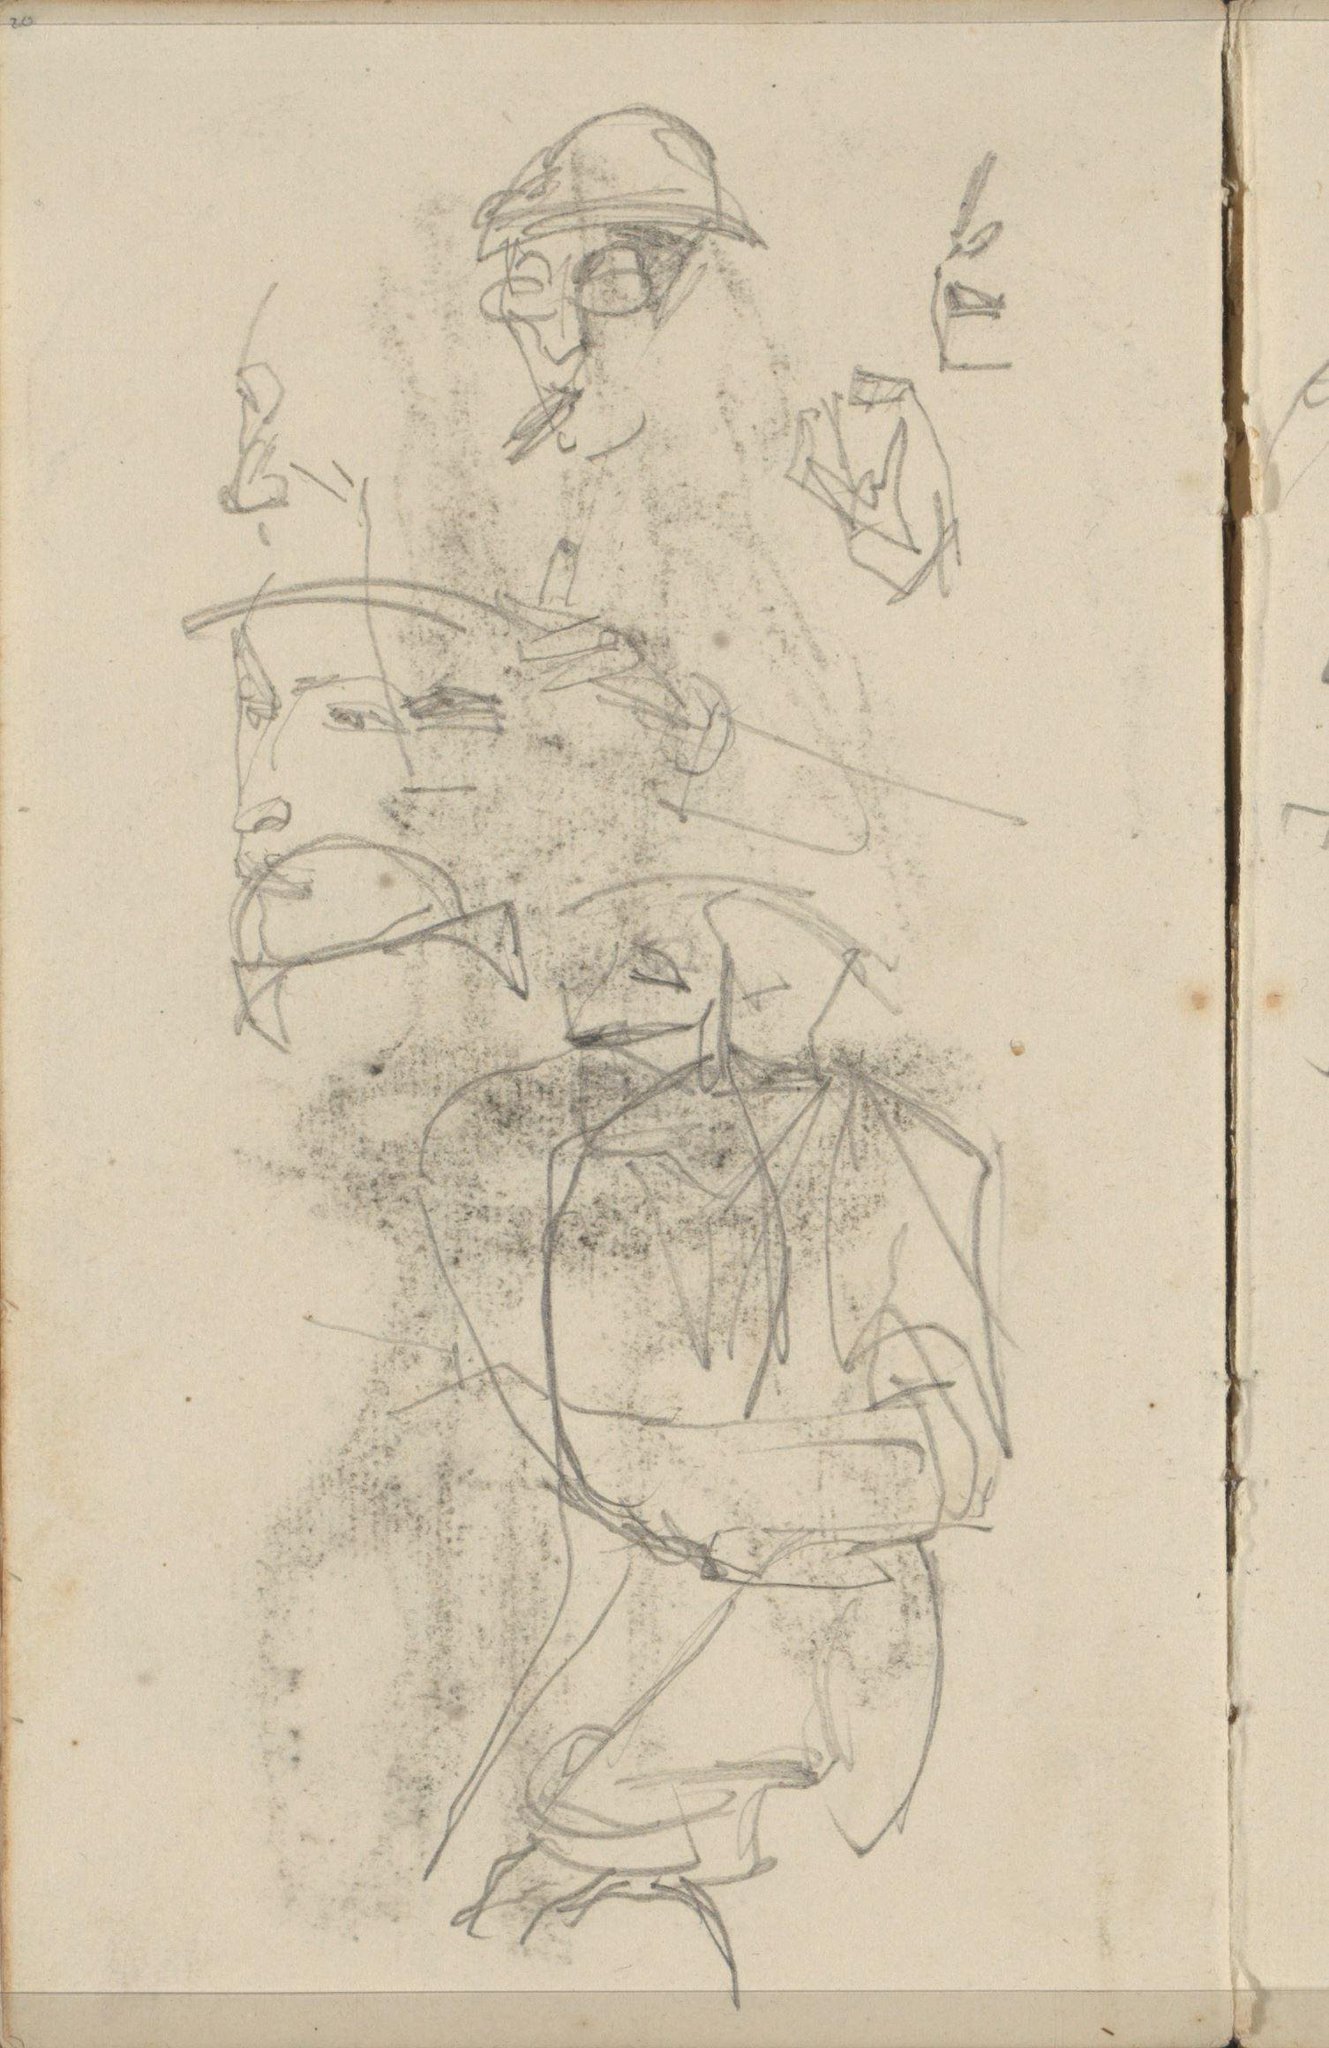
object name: sketchbook leaf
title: Figuurstudies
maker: george hendrik breitner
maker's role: draughtsman, painter, print maker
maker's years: 1857-1923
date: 1880-1882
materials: paper, pencil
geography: the hague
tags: head (human), adult man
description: Pagina 20 uit een schetsboek met 25 bladen.